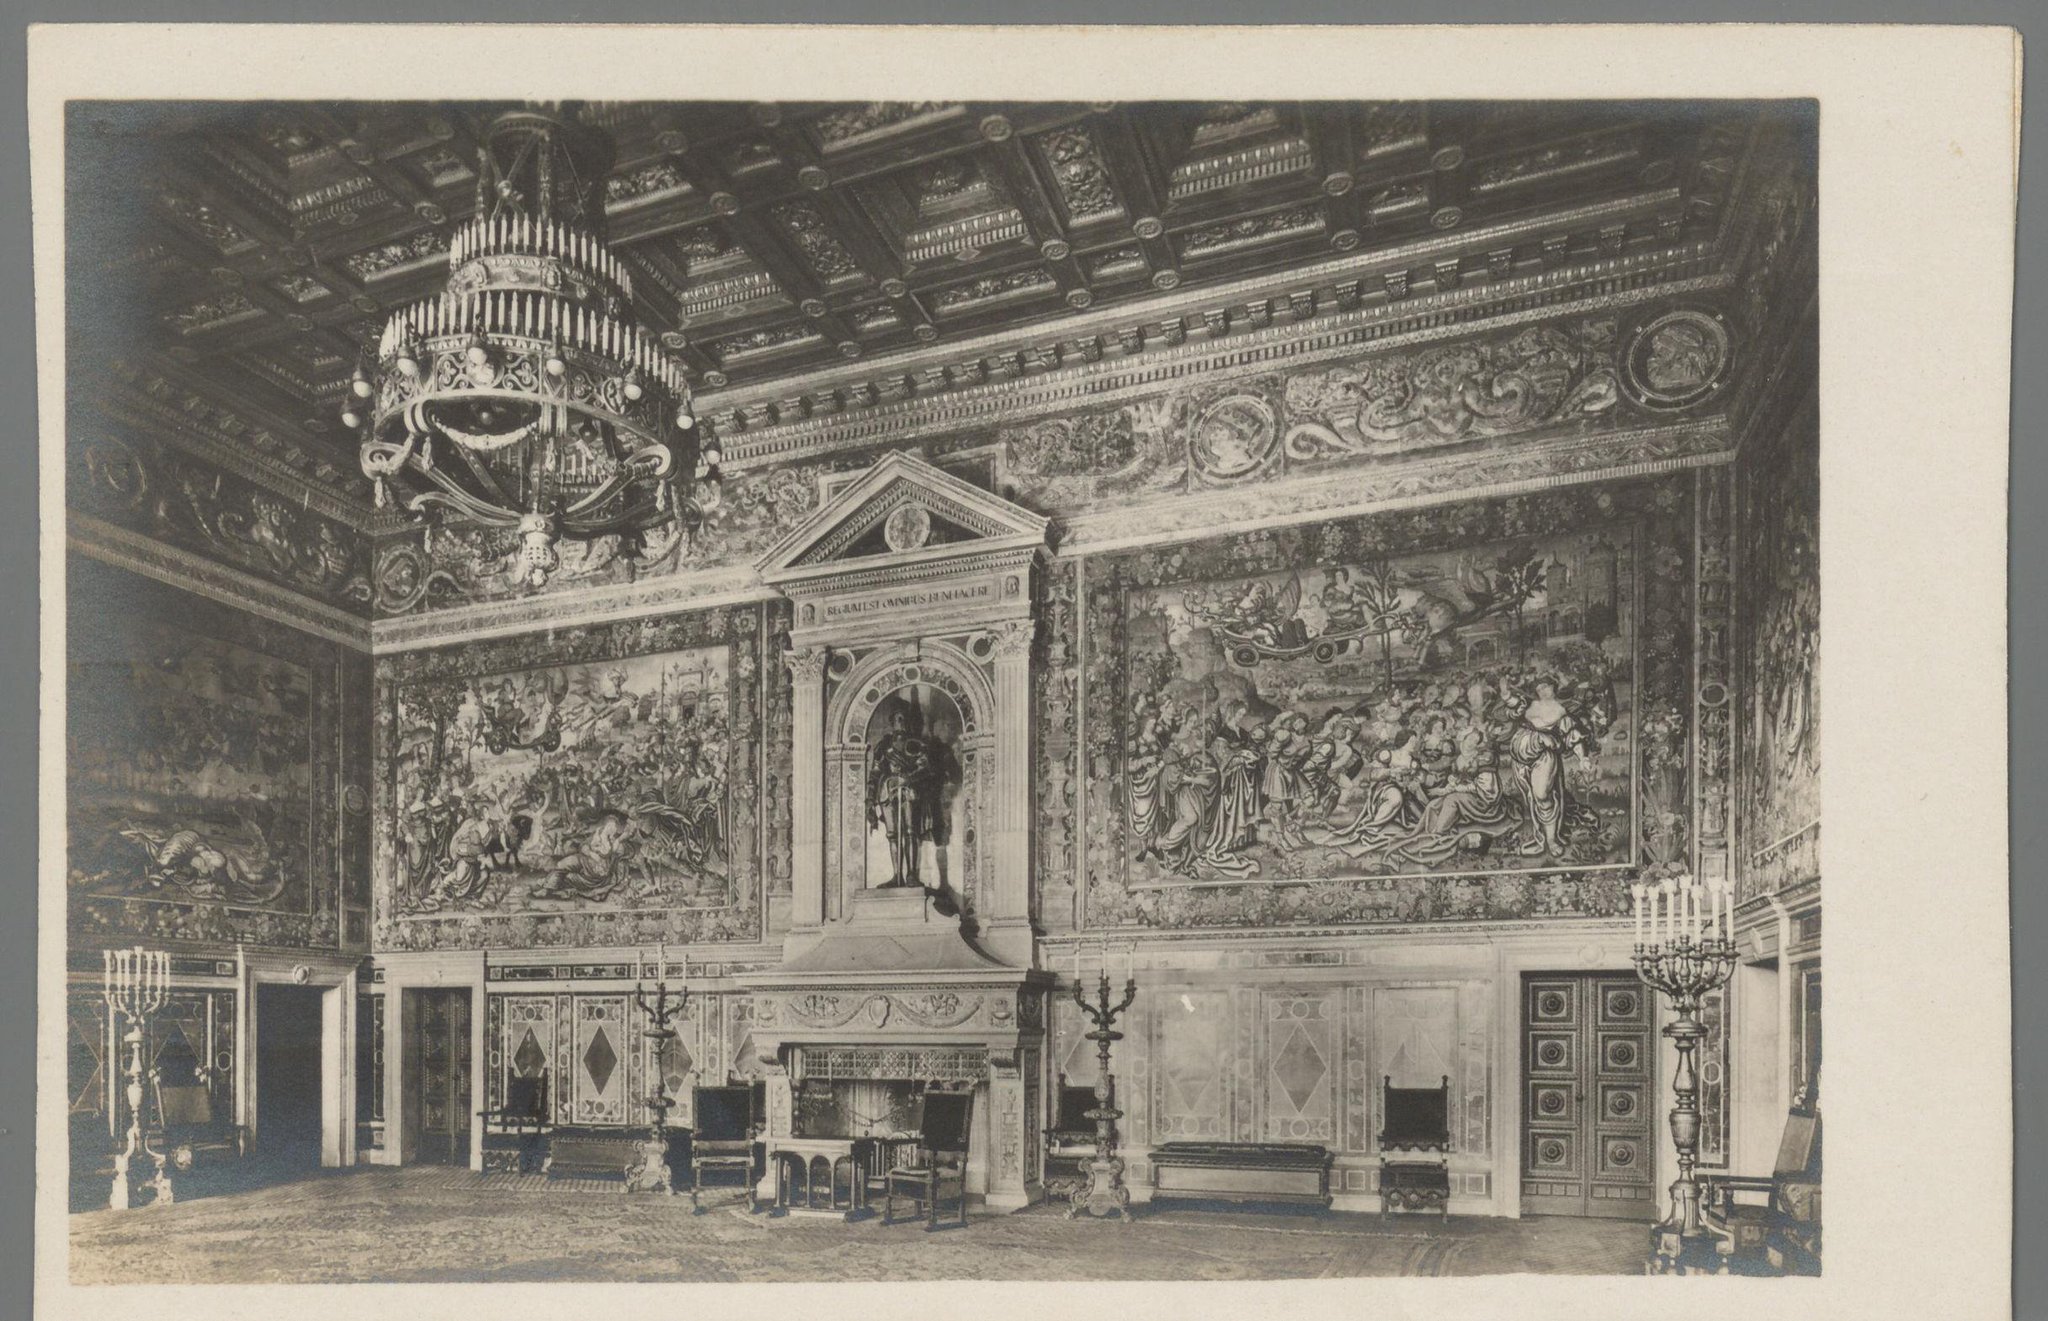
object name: ansichtkaart, prentbriefkaart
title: Schlossmuseum Berlin. Joachimssaal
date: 1918-1930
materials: photographic support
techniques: photography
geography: berlin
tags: castle, interior of the house, permanent exhibition, museum